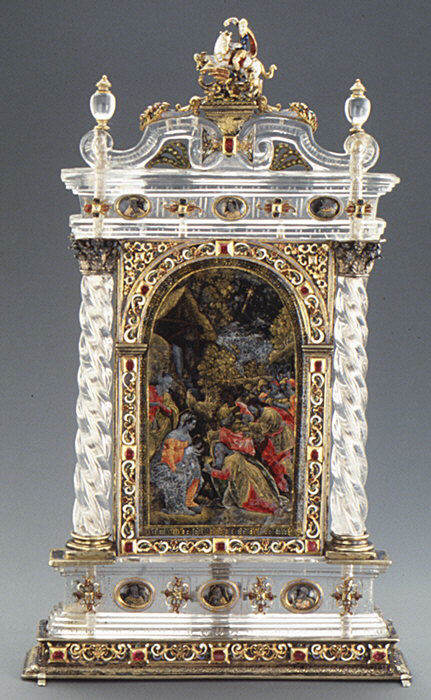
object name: pax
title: Adoration of the Magi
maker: reinhold vasters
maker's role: designer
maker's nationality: german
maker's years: 1827-1909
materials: enamel, quartz, gemstone, silver gilt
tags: adoration of the magi